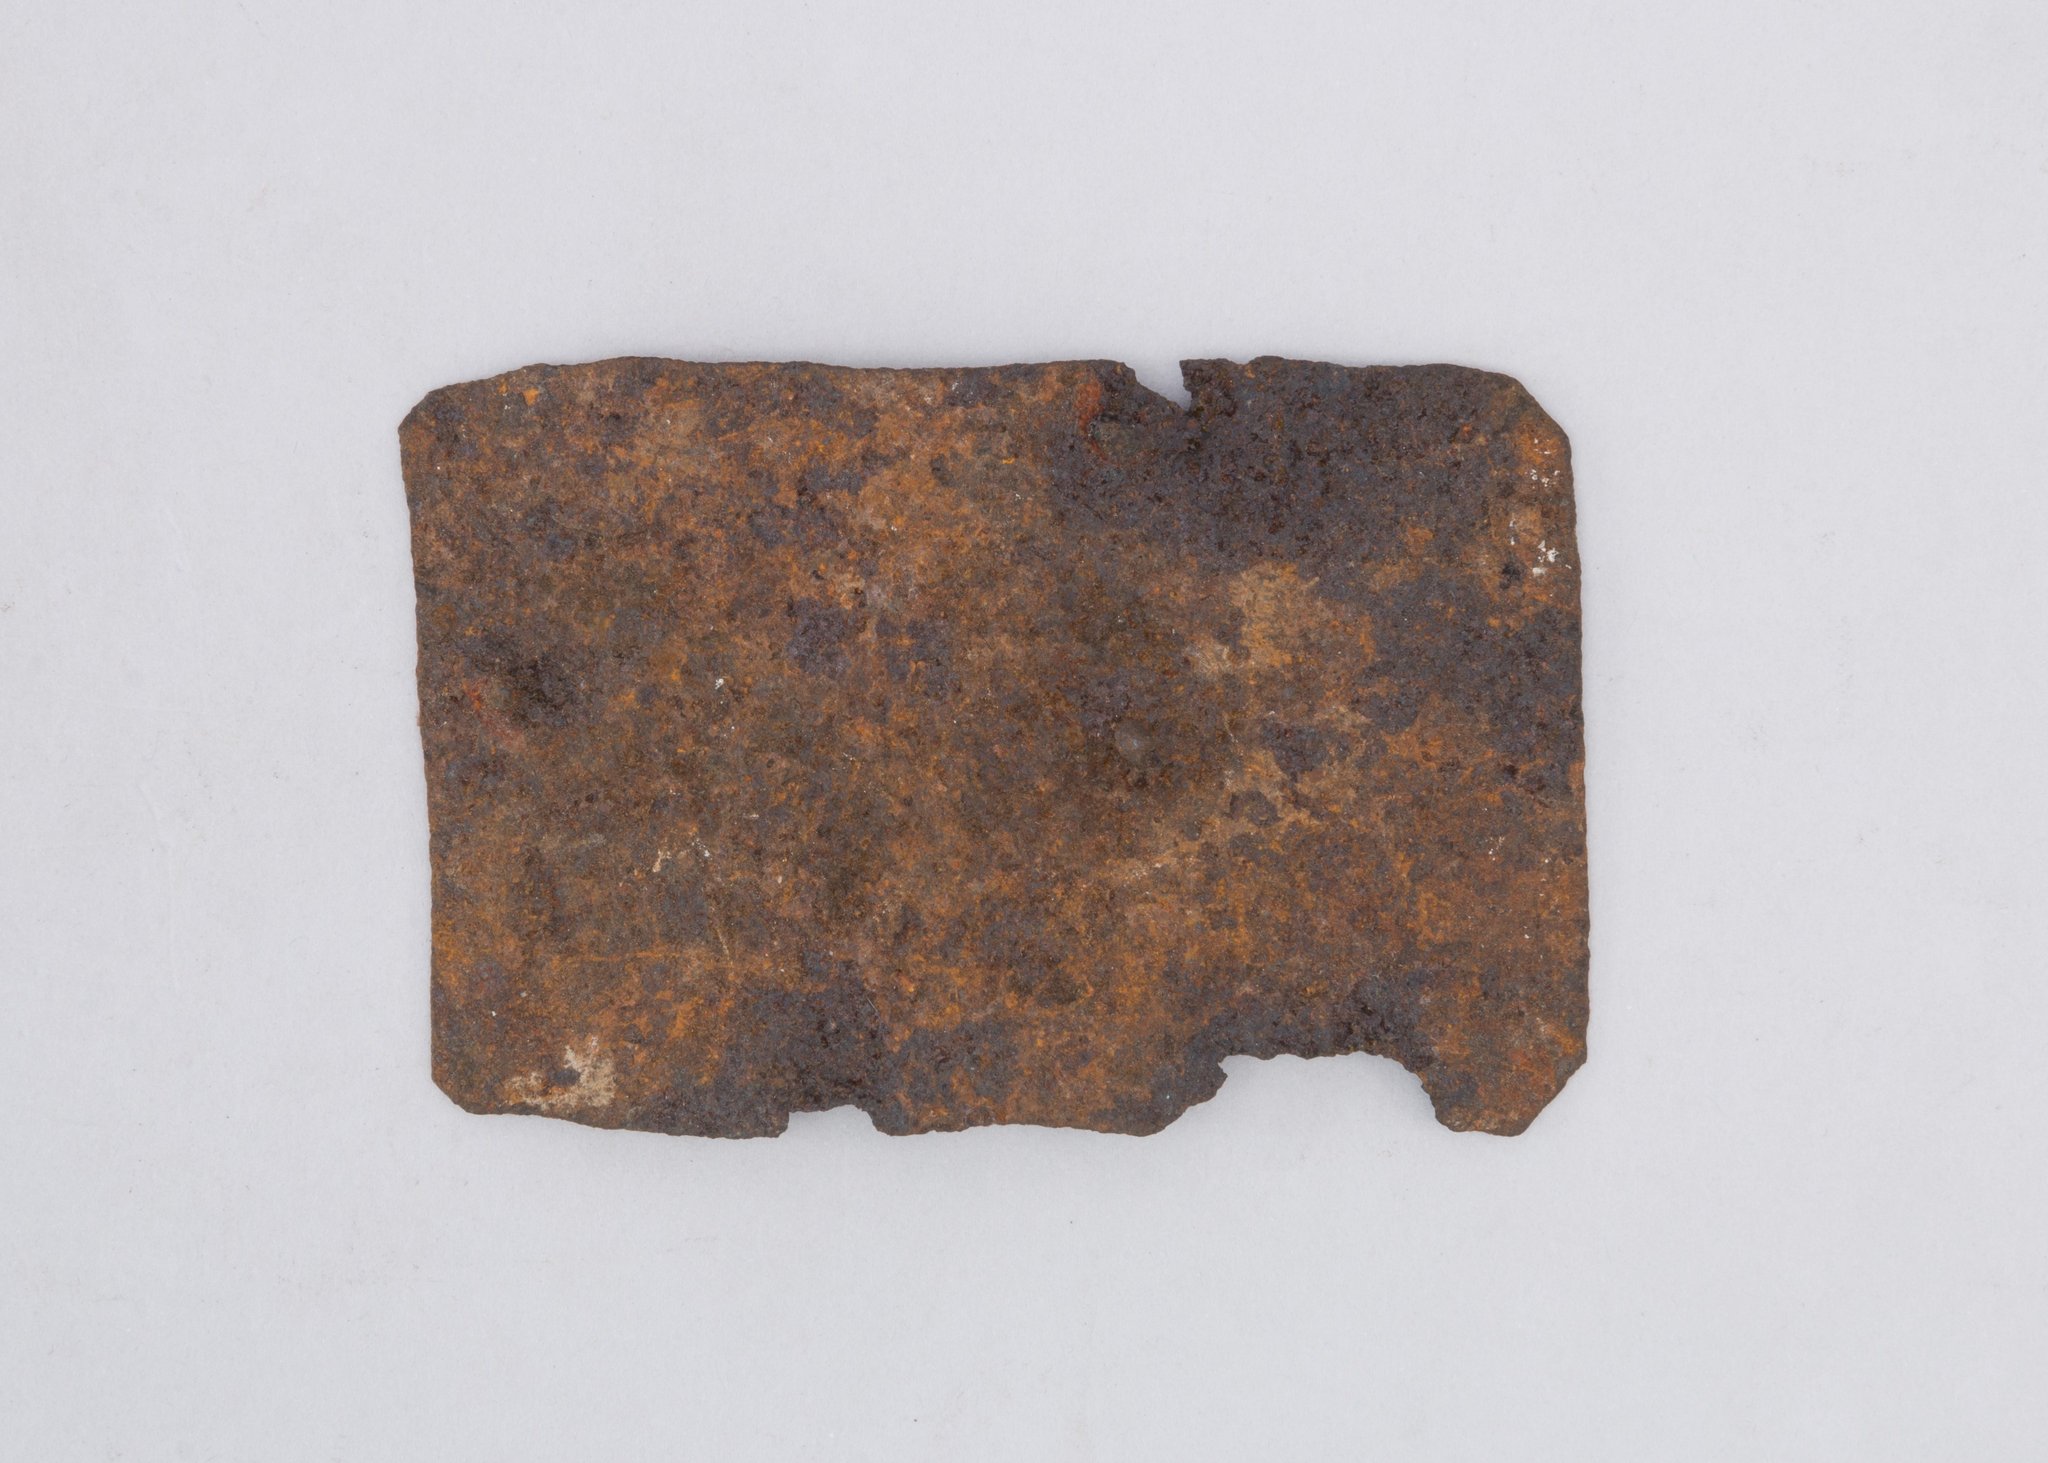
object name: six brigandine plate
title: Six Brigandine Plates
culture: european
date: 1401-1500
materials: copper alloy, iron, textile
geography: greece